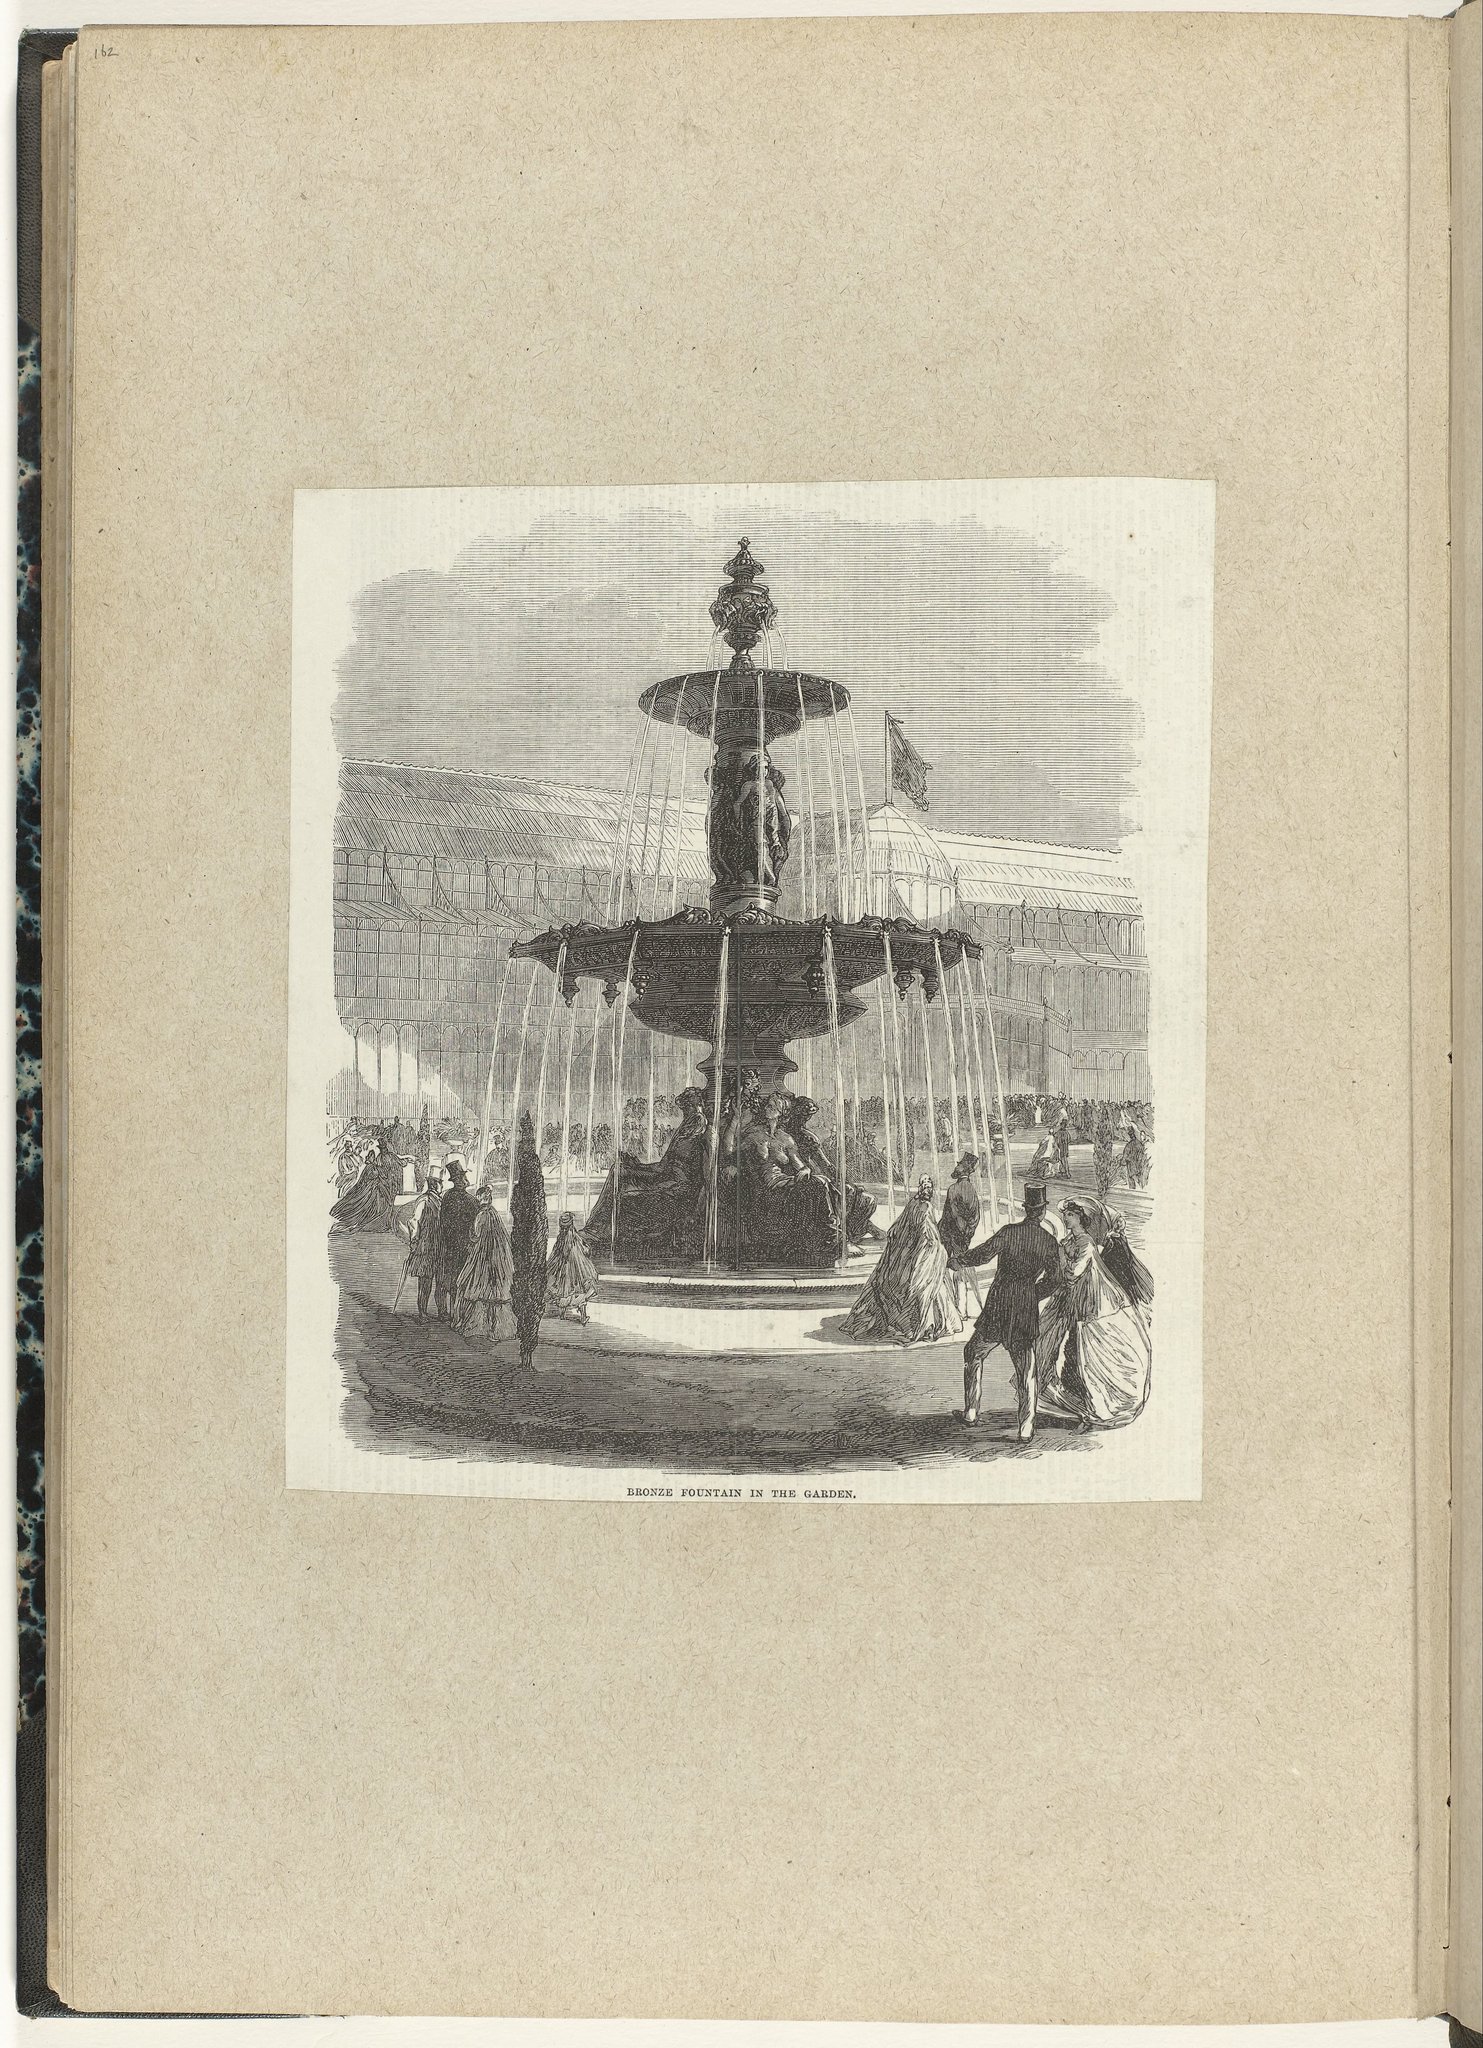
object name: print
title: Bronzen fontein in de tuin van de Royal Horticultural Society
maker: Anonymous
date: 1866-1900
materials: paper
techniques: engraving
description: Fontein bestaande uit drie bassins, tegen de voet zitten meerdere figuren. Rondom de fontein lopen mensen.